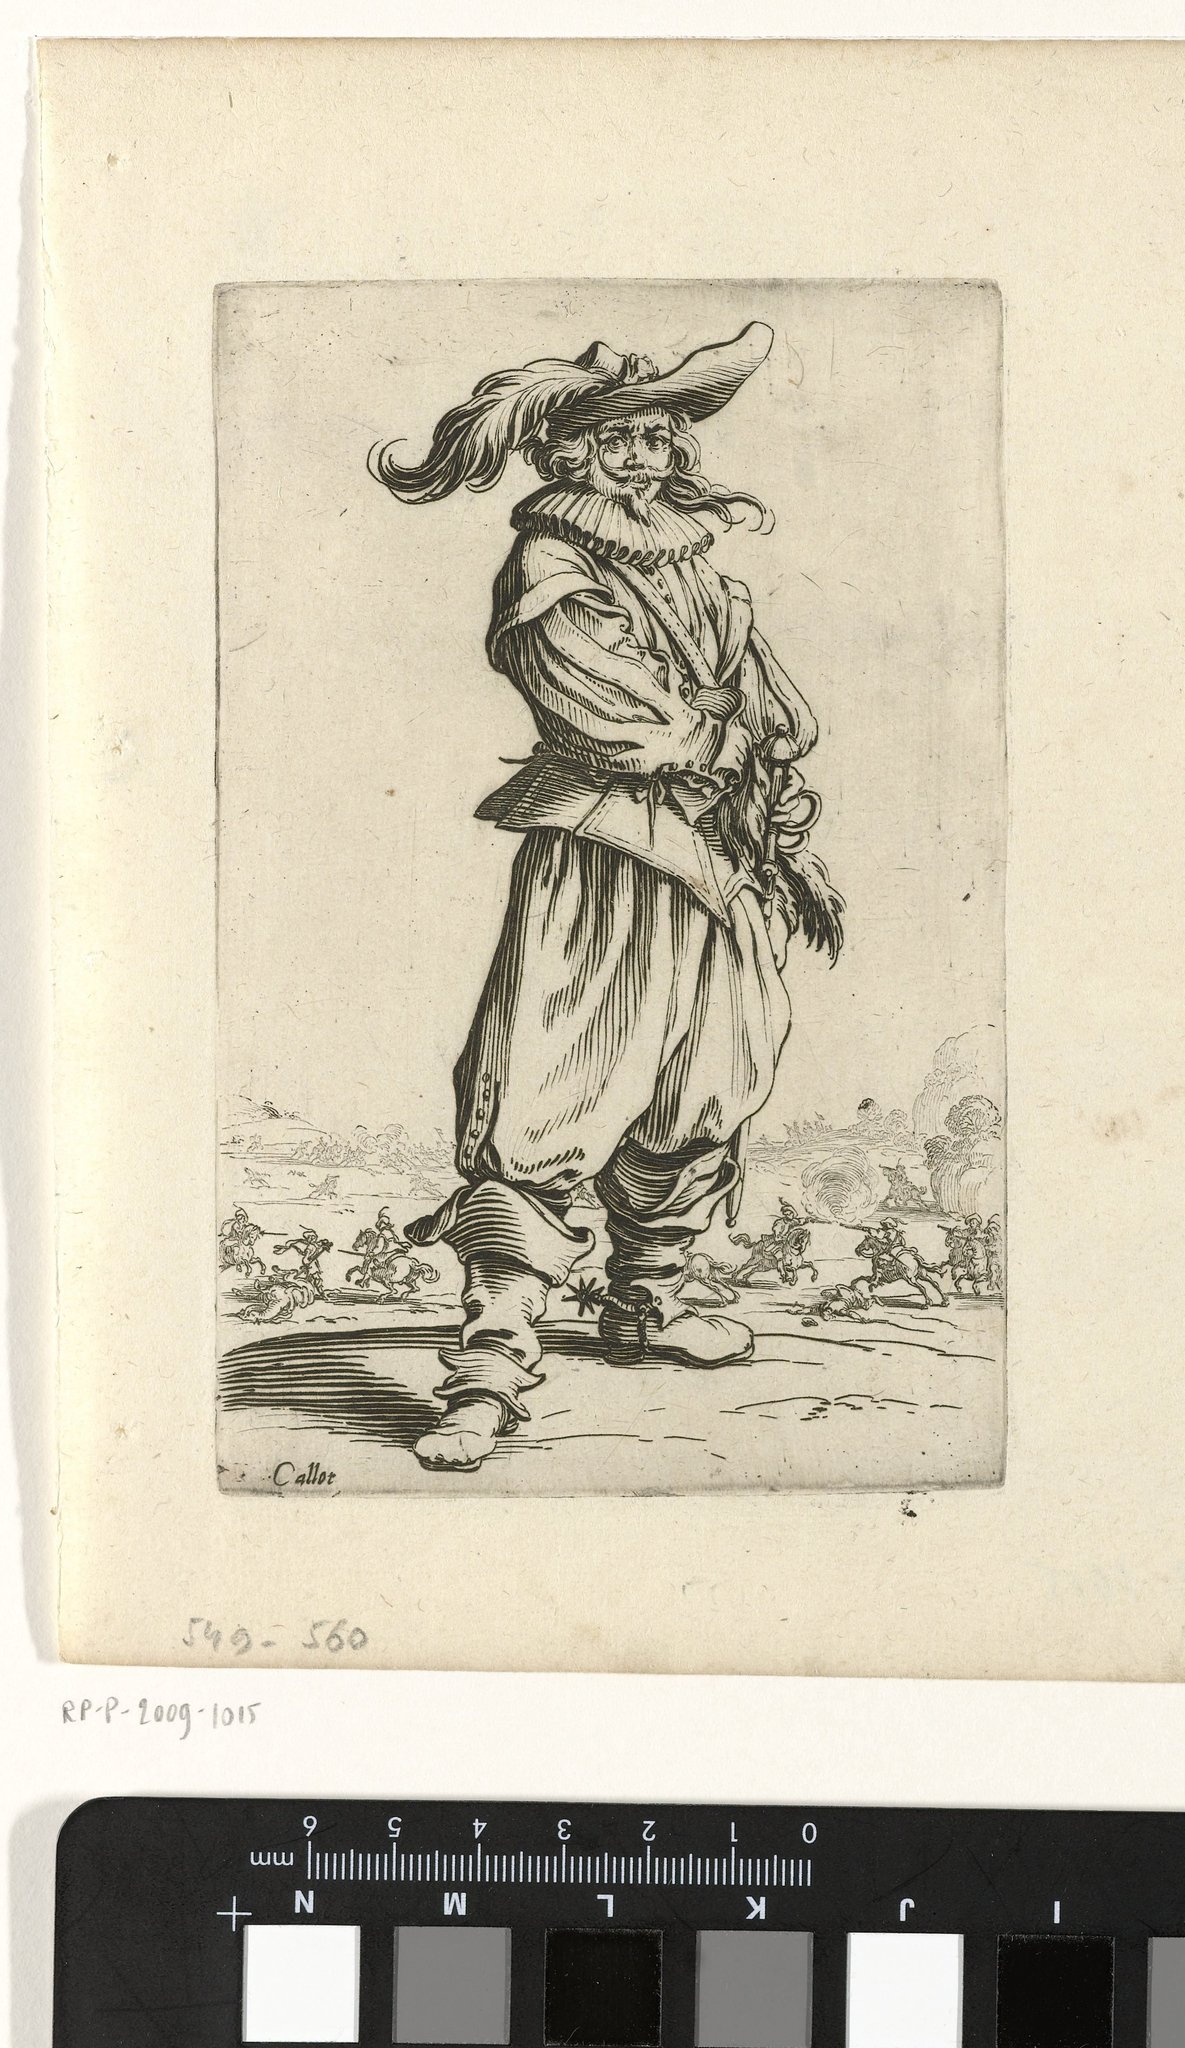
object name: print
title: La Noblesse de Lorraine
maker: jacques callot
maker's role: draughtsman, print maker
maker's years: 1592-1635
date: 1624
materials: paper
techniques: etching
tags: neck-gear ~ clothing (with name) (+ men's clothes), hacking and thrusting weapons: dagger, head-gear: hat (+ men's clothes), clothes, costume (+ men's clothes), spur, trousers, breeches, etc. (breeches) (+ men's clothes), clothing for the upper part of the body (doublet) (+ men's clothes), boots (+ men's clothes), sleeves (+ men's clothes), head-gear: hat (+ feathers used for clothes), nobility and patriciate; chivalry, knighthood, france